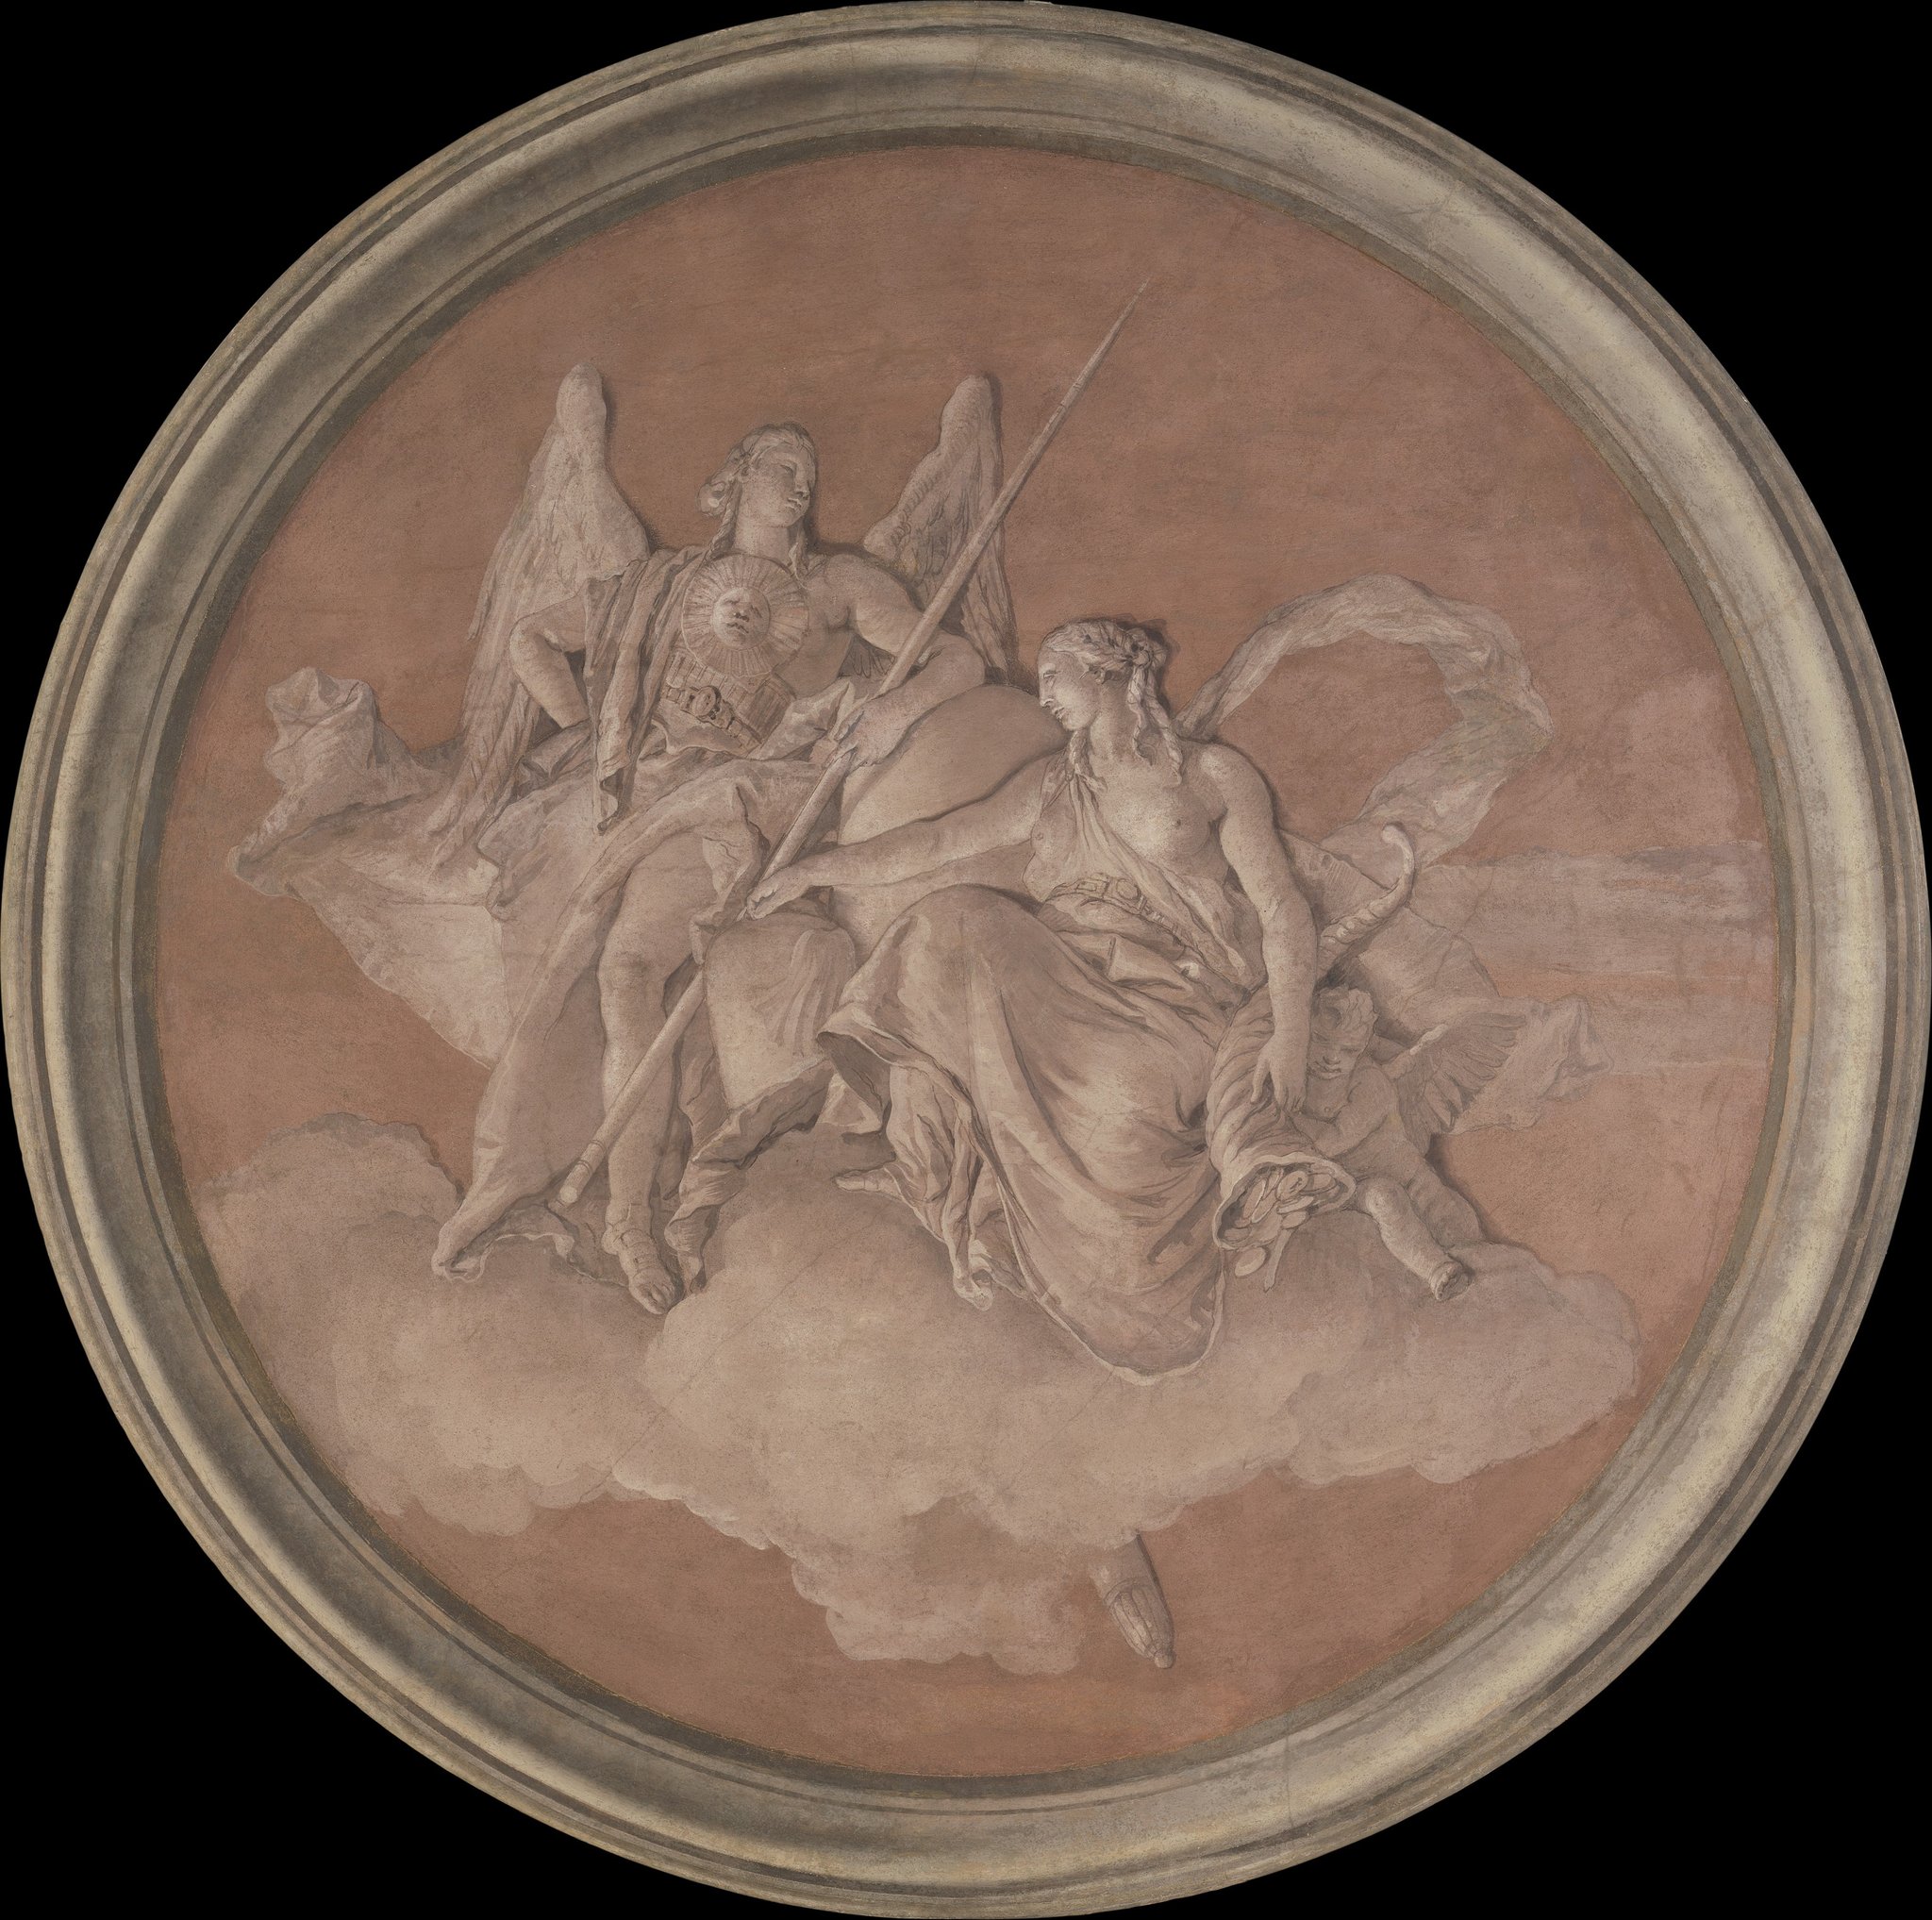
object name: painting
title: Allegorical Figures Representing Virtue and Abundance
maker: giovanni battista tiepolo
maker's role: artist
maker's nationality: italian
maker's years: 1696-1770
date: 1760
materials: canvas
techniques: fresco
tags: female nudes,putti